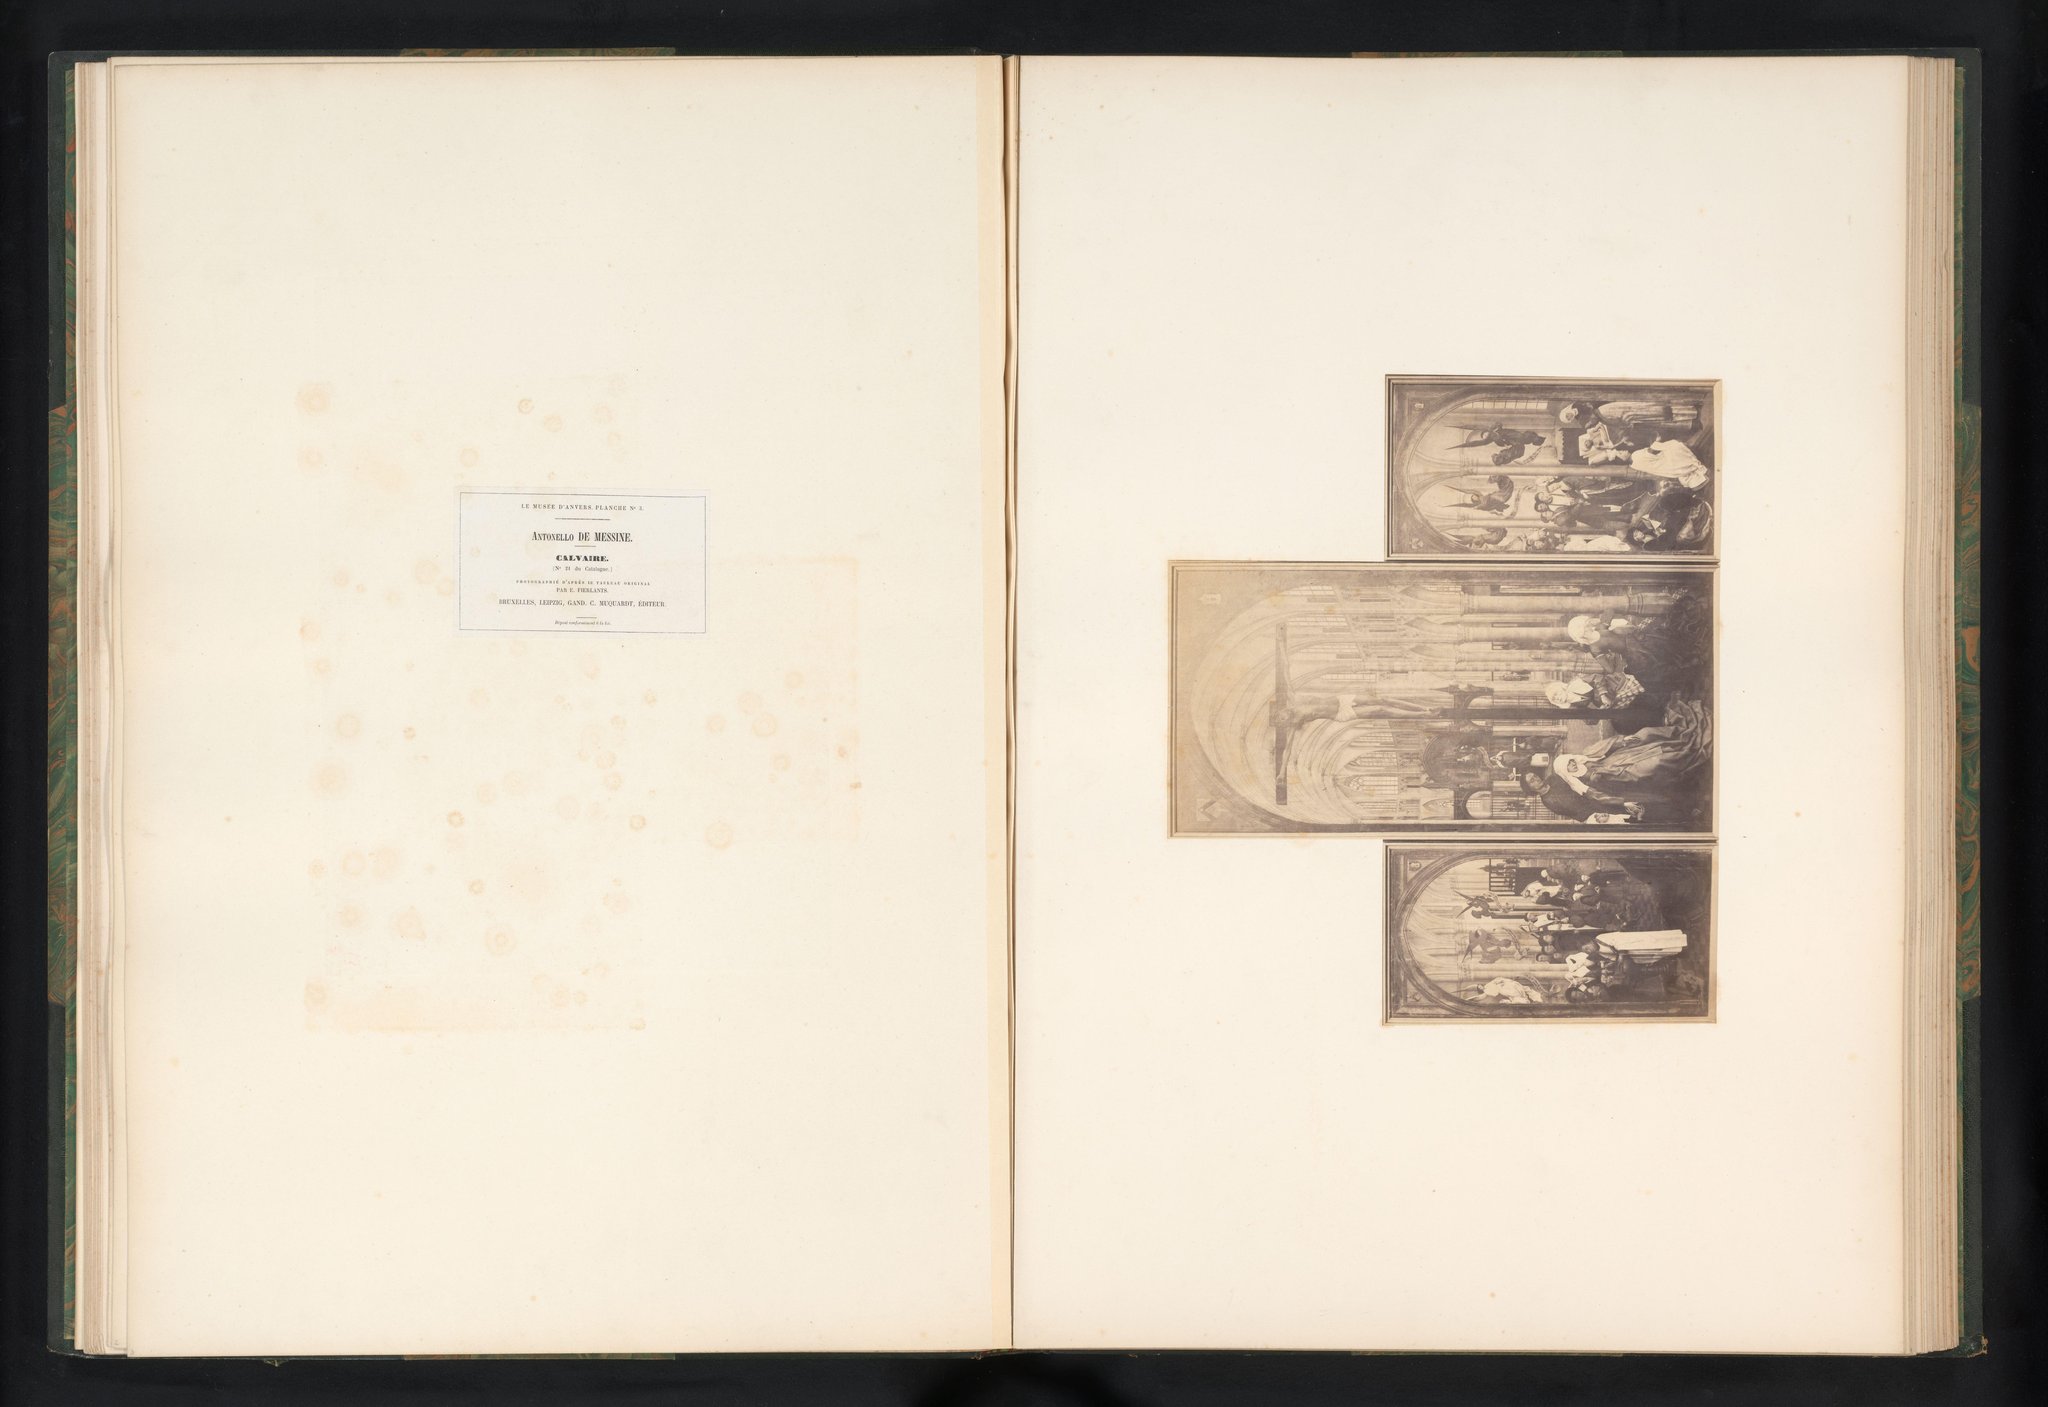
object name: photograph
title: Fotoreproductie van De Zeven Sacramenten door Rogier van der Weyden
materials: photographic support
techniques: albumen print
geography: brussels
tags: the seven sacraments of the roman catholic church